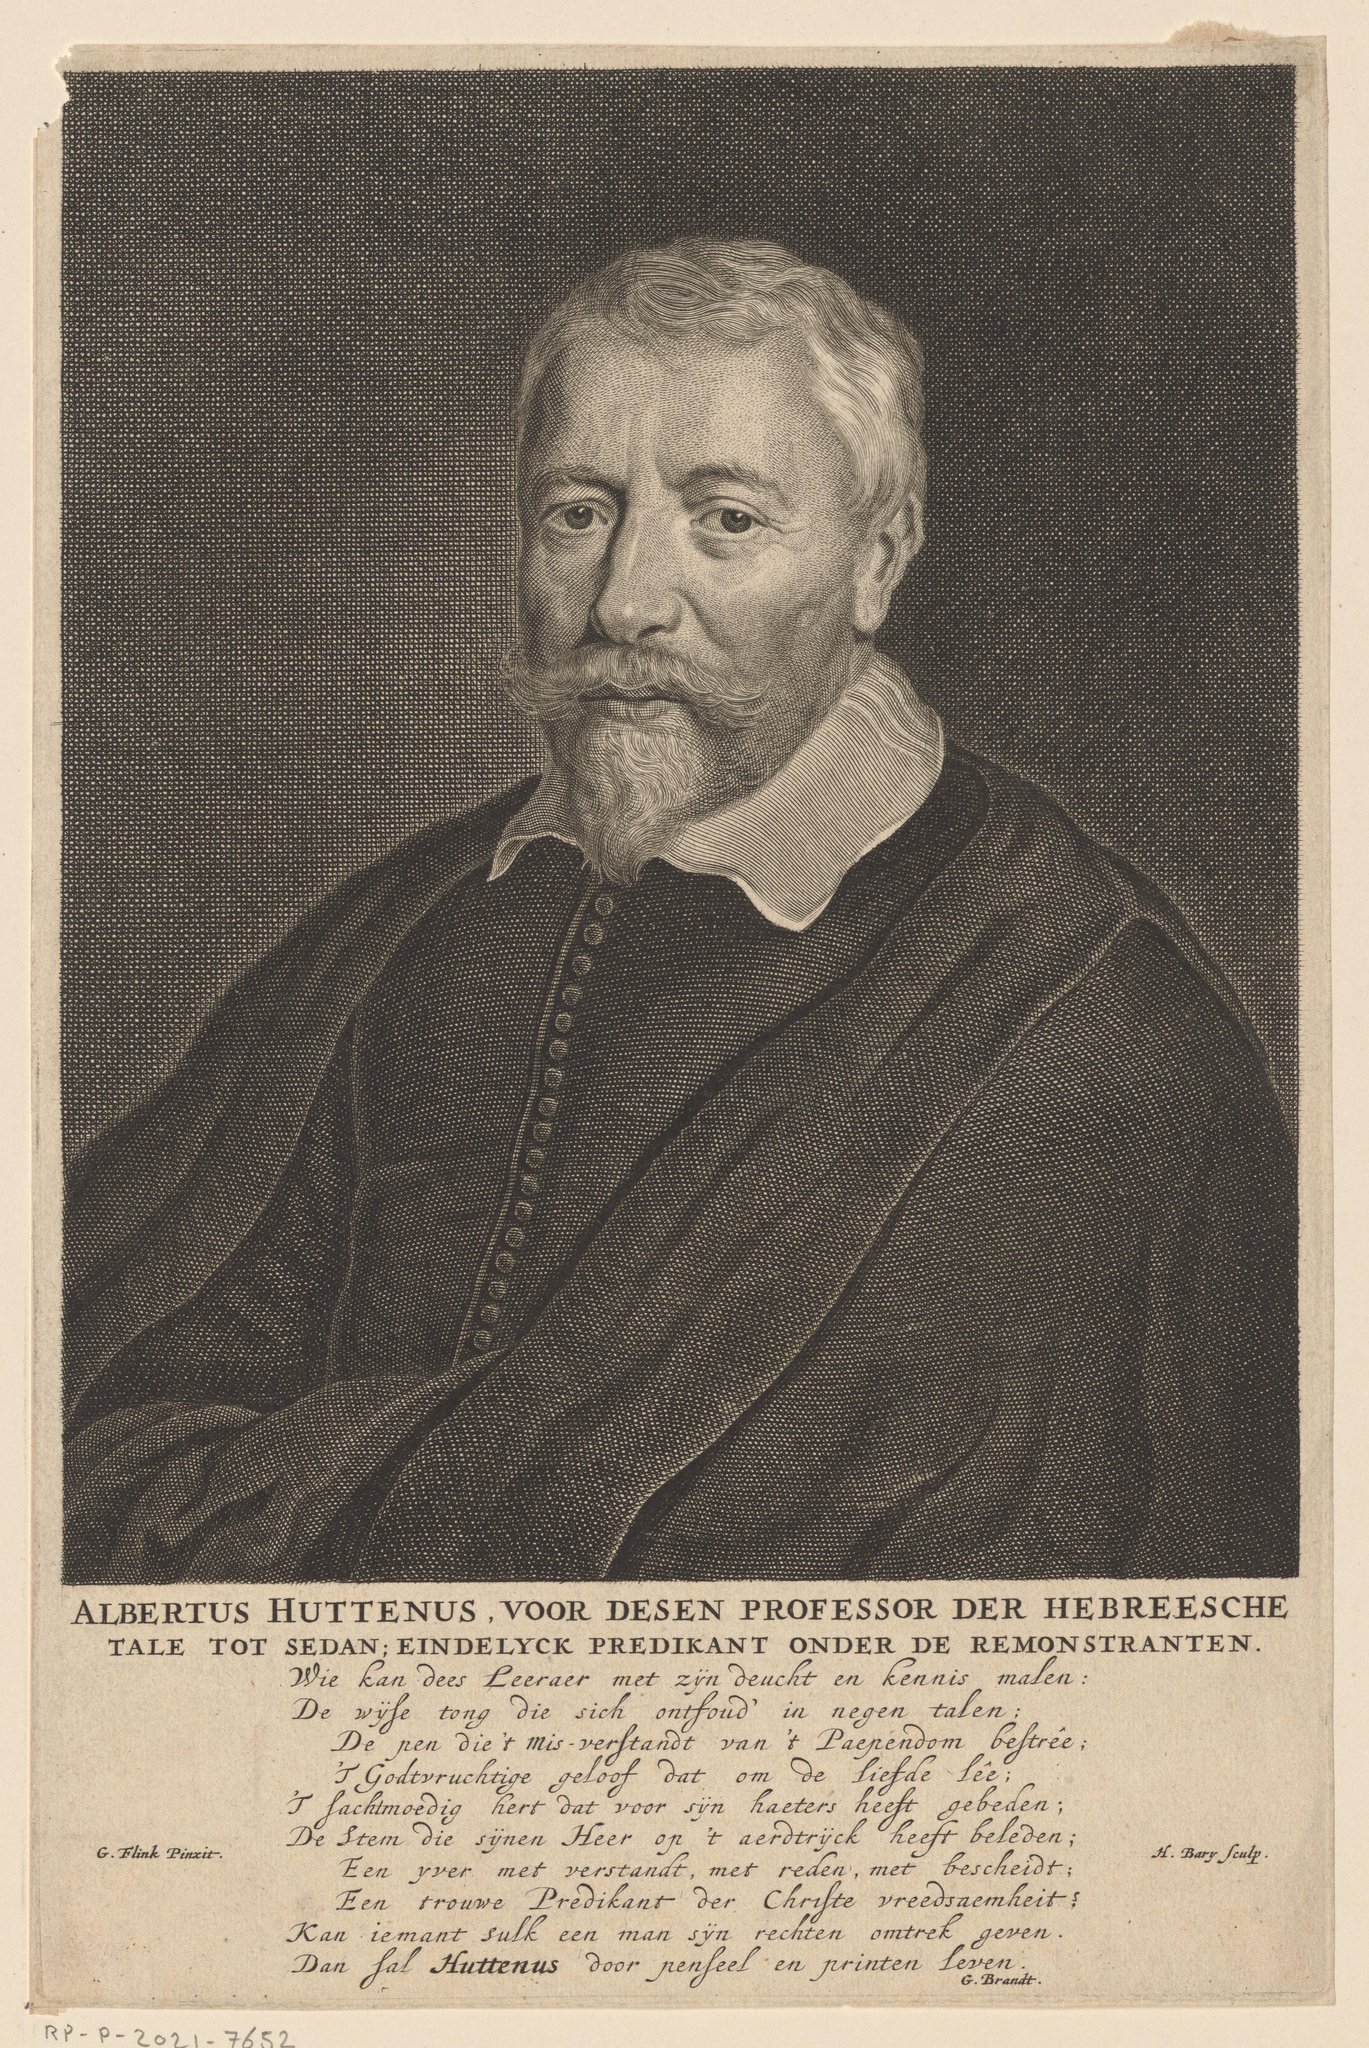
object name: print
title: Portret van Albertus Huttenus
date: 1657-1707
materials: paper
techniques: engraving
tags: historical persons, functionaries and dignitaries ~ episcopal protestant churches, professor